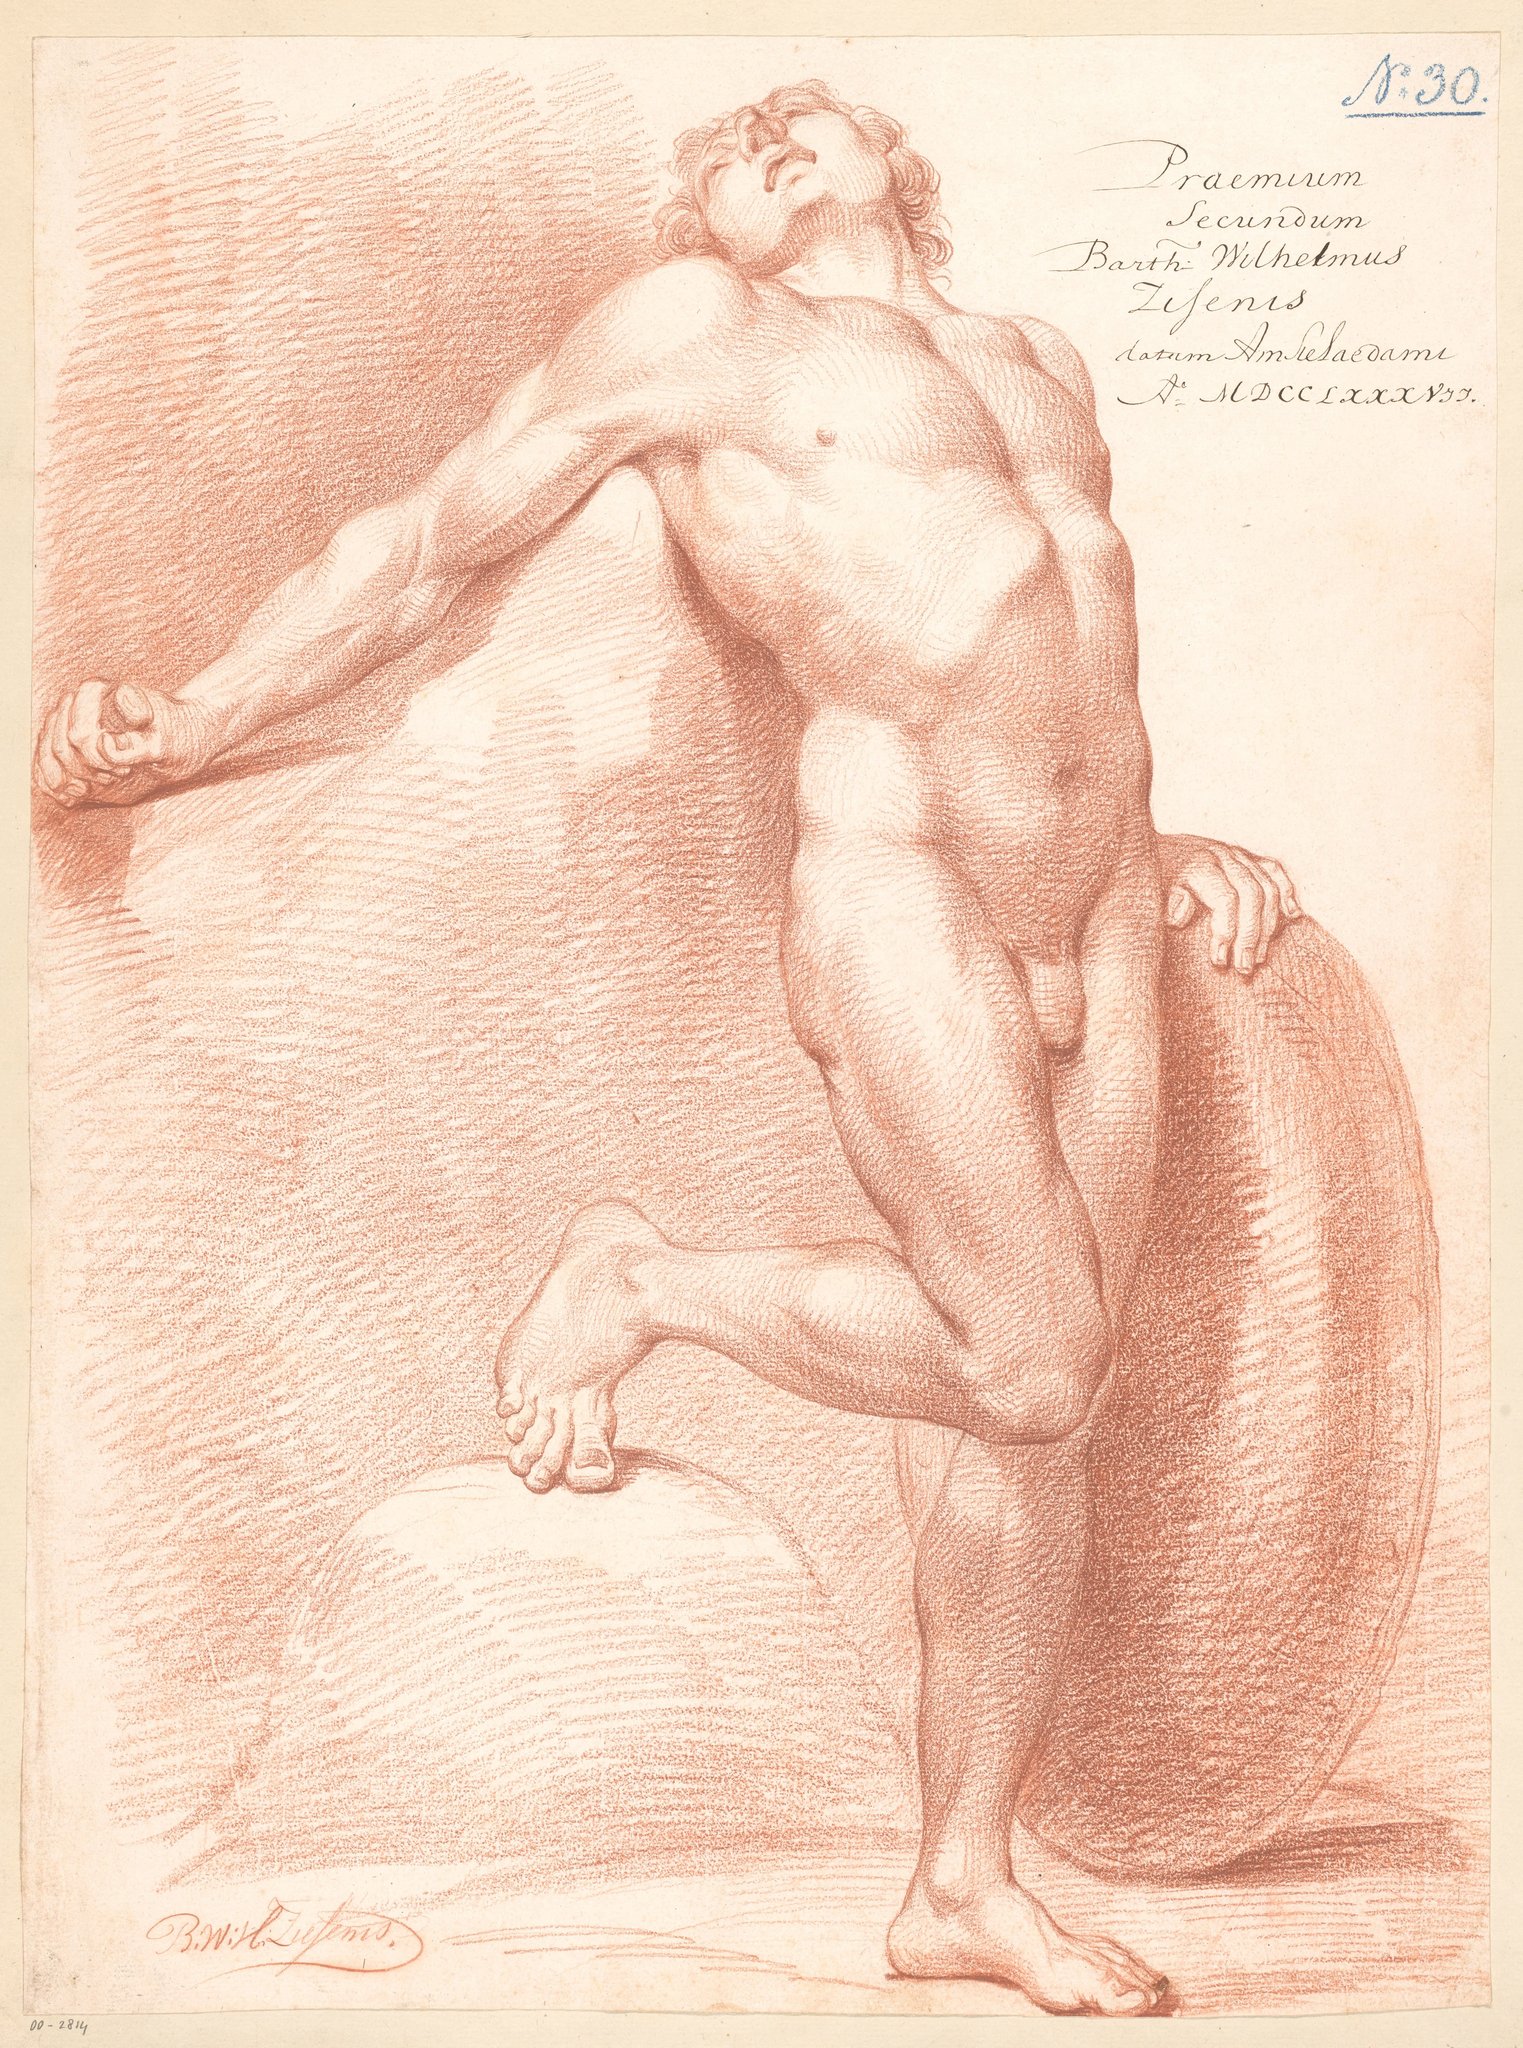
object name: drawing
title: Staand mannelijk naakt, van voren gezien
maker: bartholomeus ziesenis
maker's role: draughtsman, sculptor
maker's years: 1768-1820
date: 1787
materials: chalk, charcoal, paper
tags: standing figure (+ nude human being)